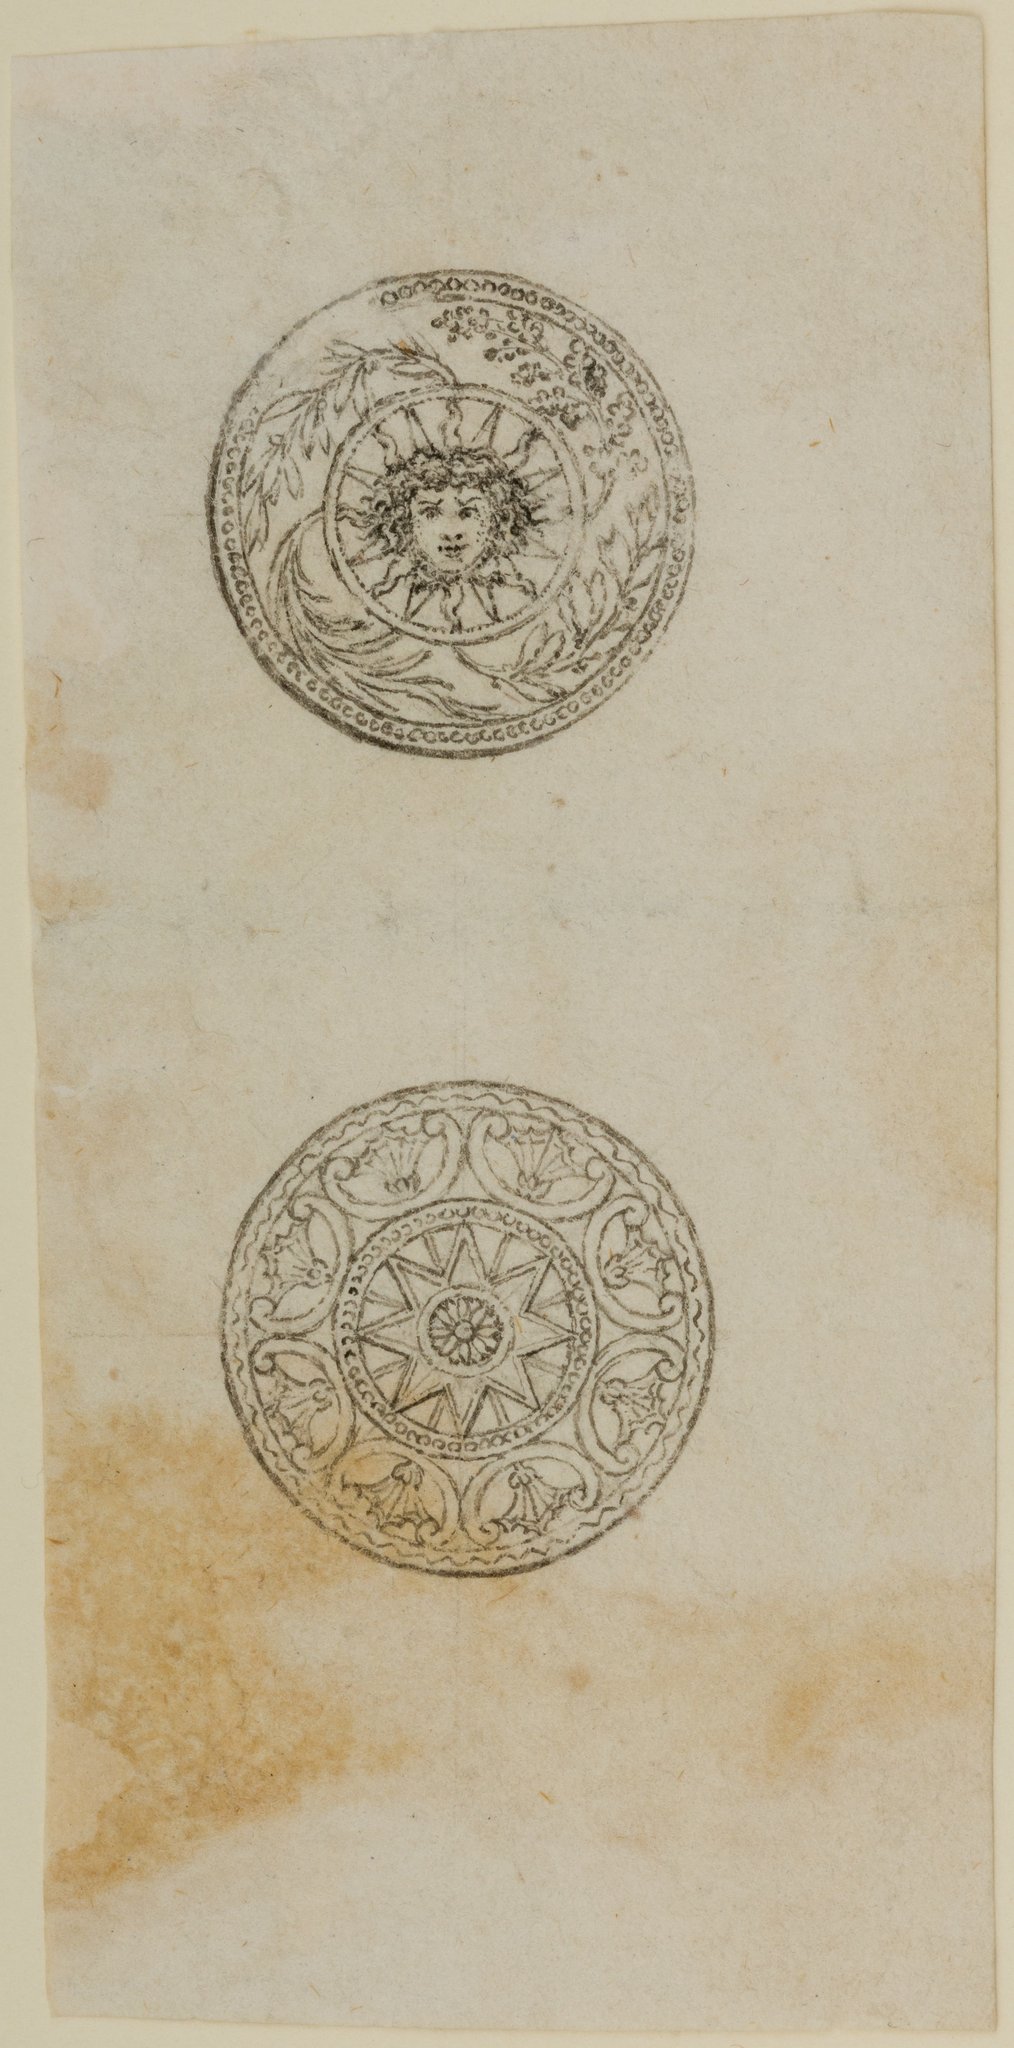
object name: drawing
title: Designs for the Decoration of Firearms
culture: french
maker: nicolas noël boutet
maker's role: designer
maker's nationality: french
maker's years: 1761-1833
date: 1797-1805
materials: ink, paper, pencil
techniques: wash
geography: france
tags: faces,stars